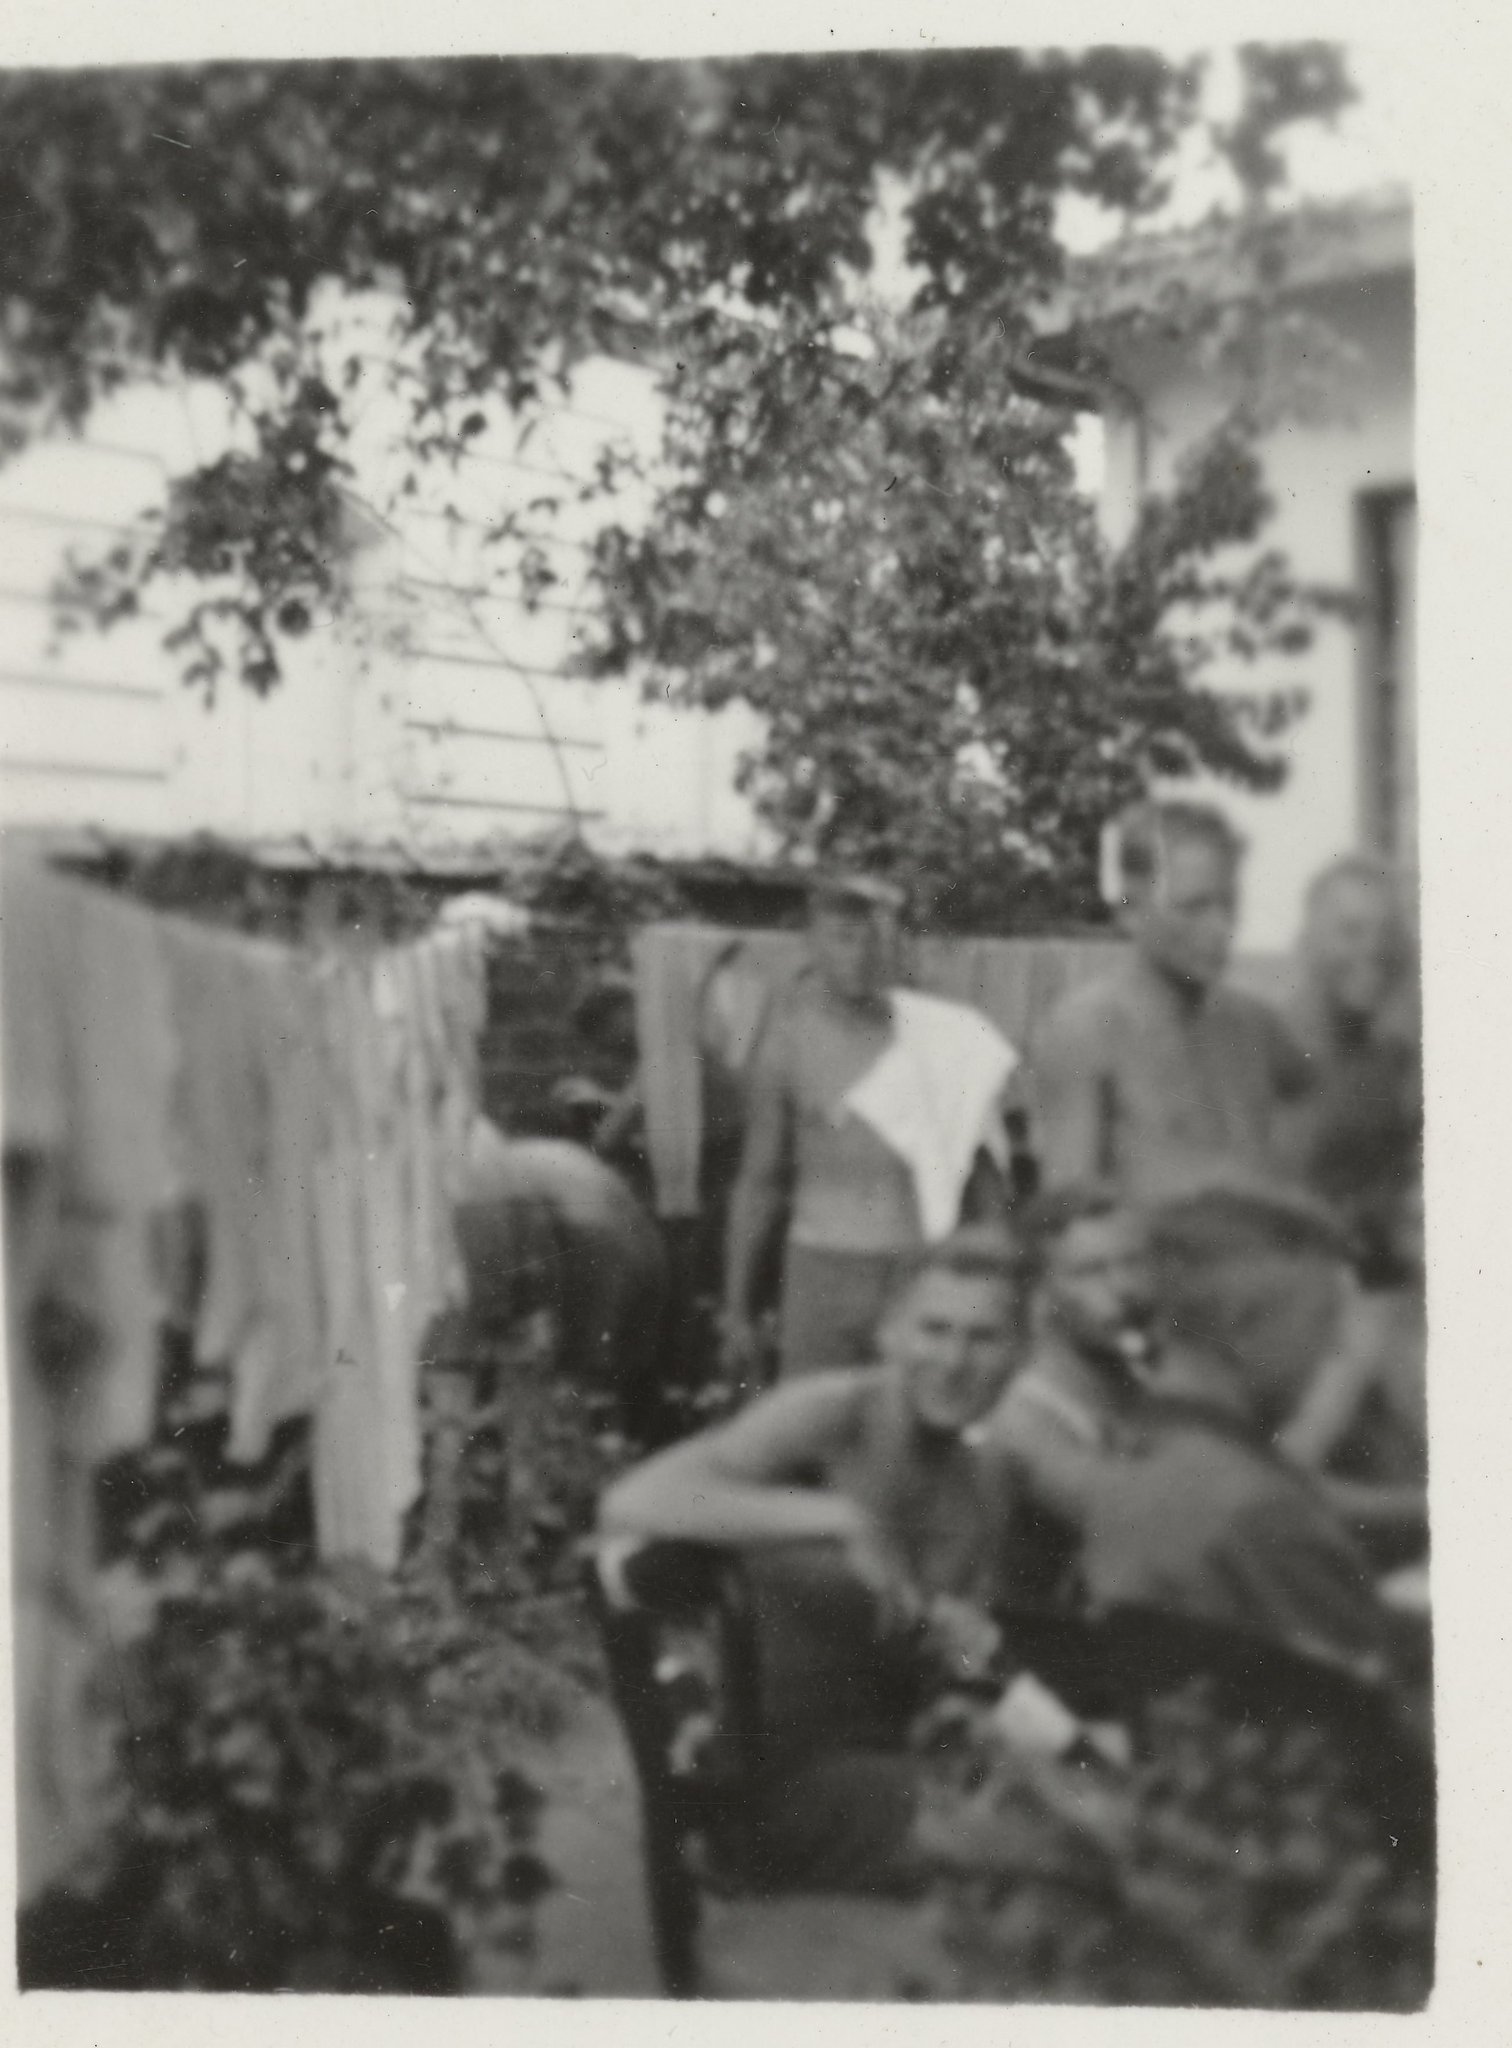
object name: photograph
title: Soldaten in een tuin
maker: Anonymous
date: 1940-1945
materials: photographic support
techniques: gelatin silver print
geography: france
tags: netherlands, germany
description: Een groep soldaten in een tuin. Achter hen hangt wasgoed. Foto behorend bij album 'Kriegserinnerungen'.